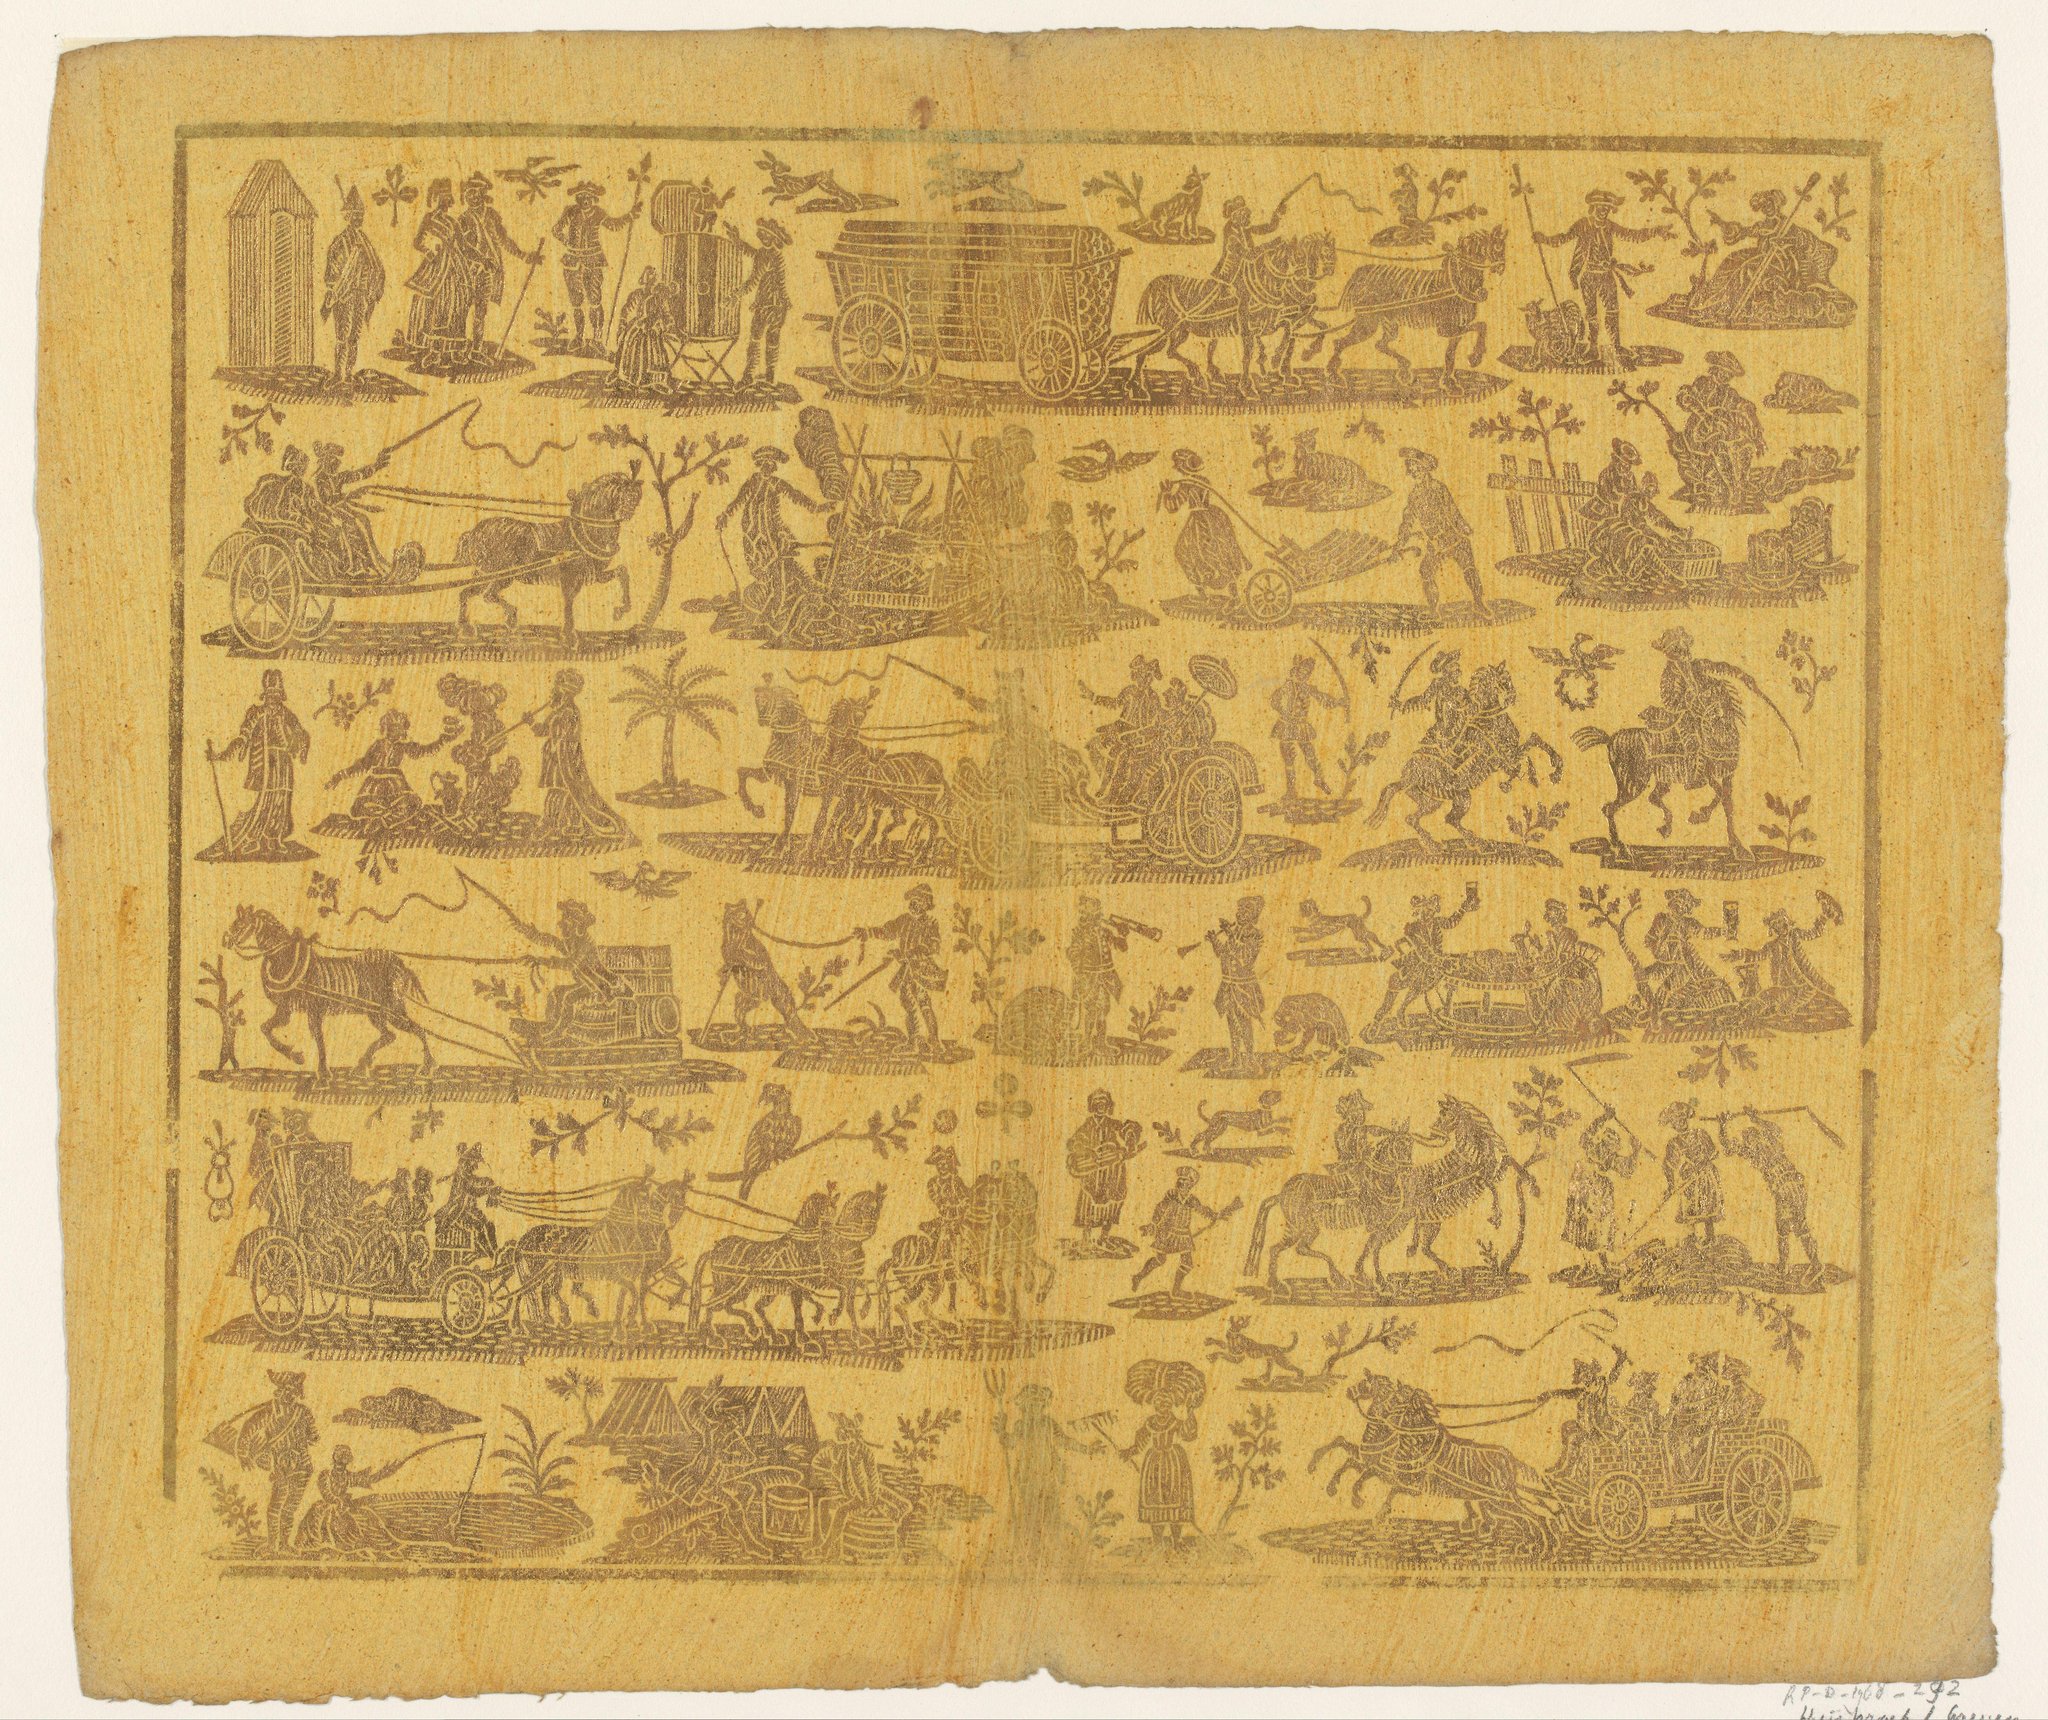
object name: print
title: Blad met zes rijen met diverse scènes uit het volksleven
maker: Anonymous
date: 1750-1800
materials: gold leaf, paint, paper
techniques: relief print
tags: traffic on land, persons engaged in trade and commerce, crafts and industries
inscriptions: collector's mark: Lugt 2228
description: Blad met zes rijen met diverse scènes uit het volksleven; linksboven soldaat op wacht, rechtsboven zittende herderin, linksonder staande man bij een zittende vissende vrouw, rechtsonder paard en wagen.